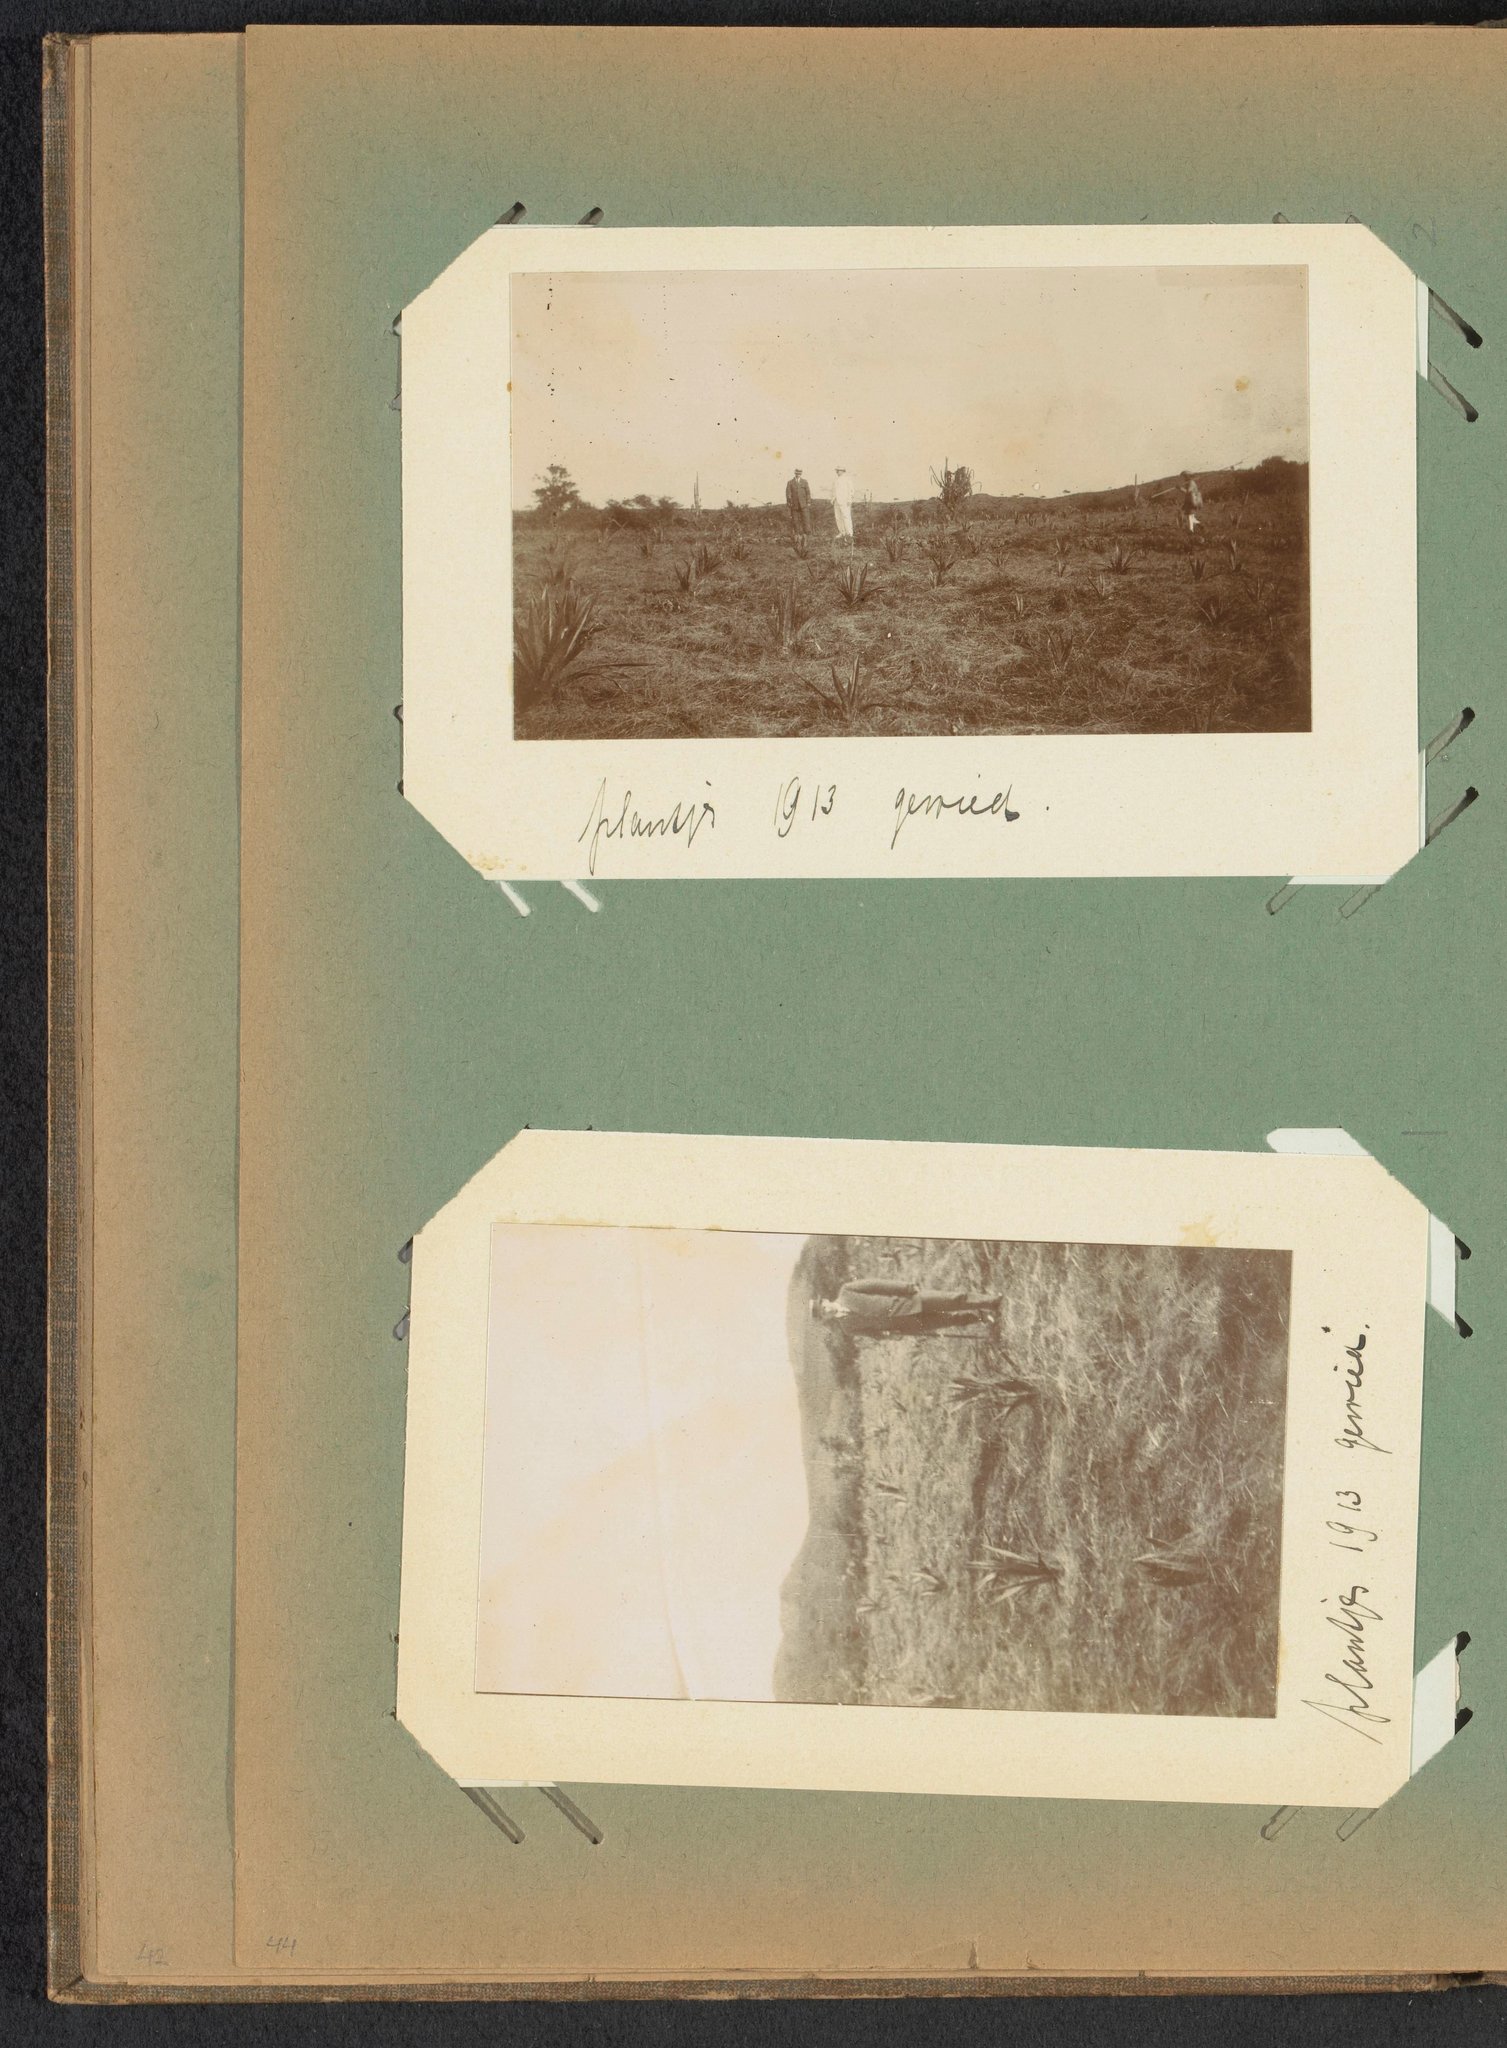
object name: photograph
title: plantjes 1913 gewied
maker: Anonymous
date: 1913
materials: paper, photographic support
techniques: gelatin silver print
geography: curacao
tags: plantation, (non-fruit) products of plants or trees: sisal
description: Gewied veld met sisalplanten in 1913 op Plantage Mount Pleasant op Curaçao. Onderdeel van het fotoalbum uit ca. 1912-1913 met 92 foto's van de plantages Peperpot en Dordrecht in Suriname en Mount Pleasant op Curaçao.